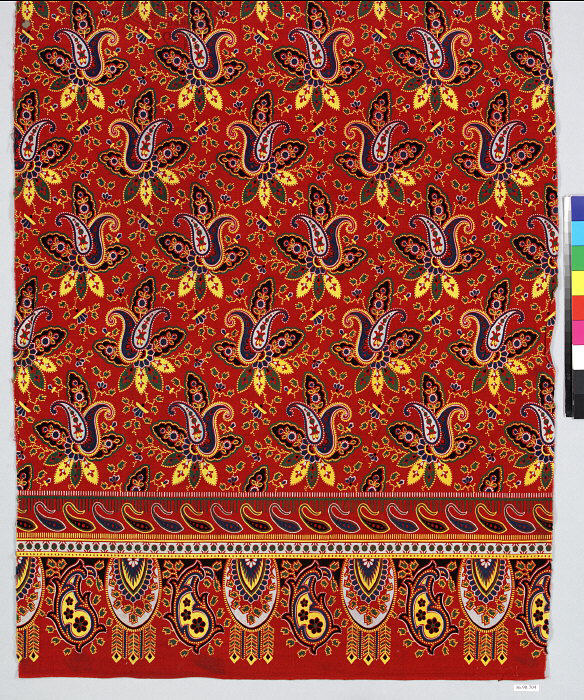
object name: piece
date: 1867-1900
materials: cotton